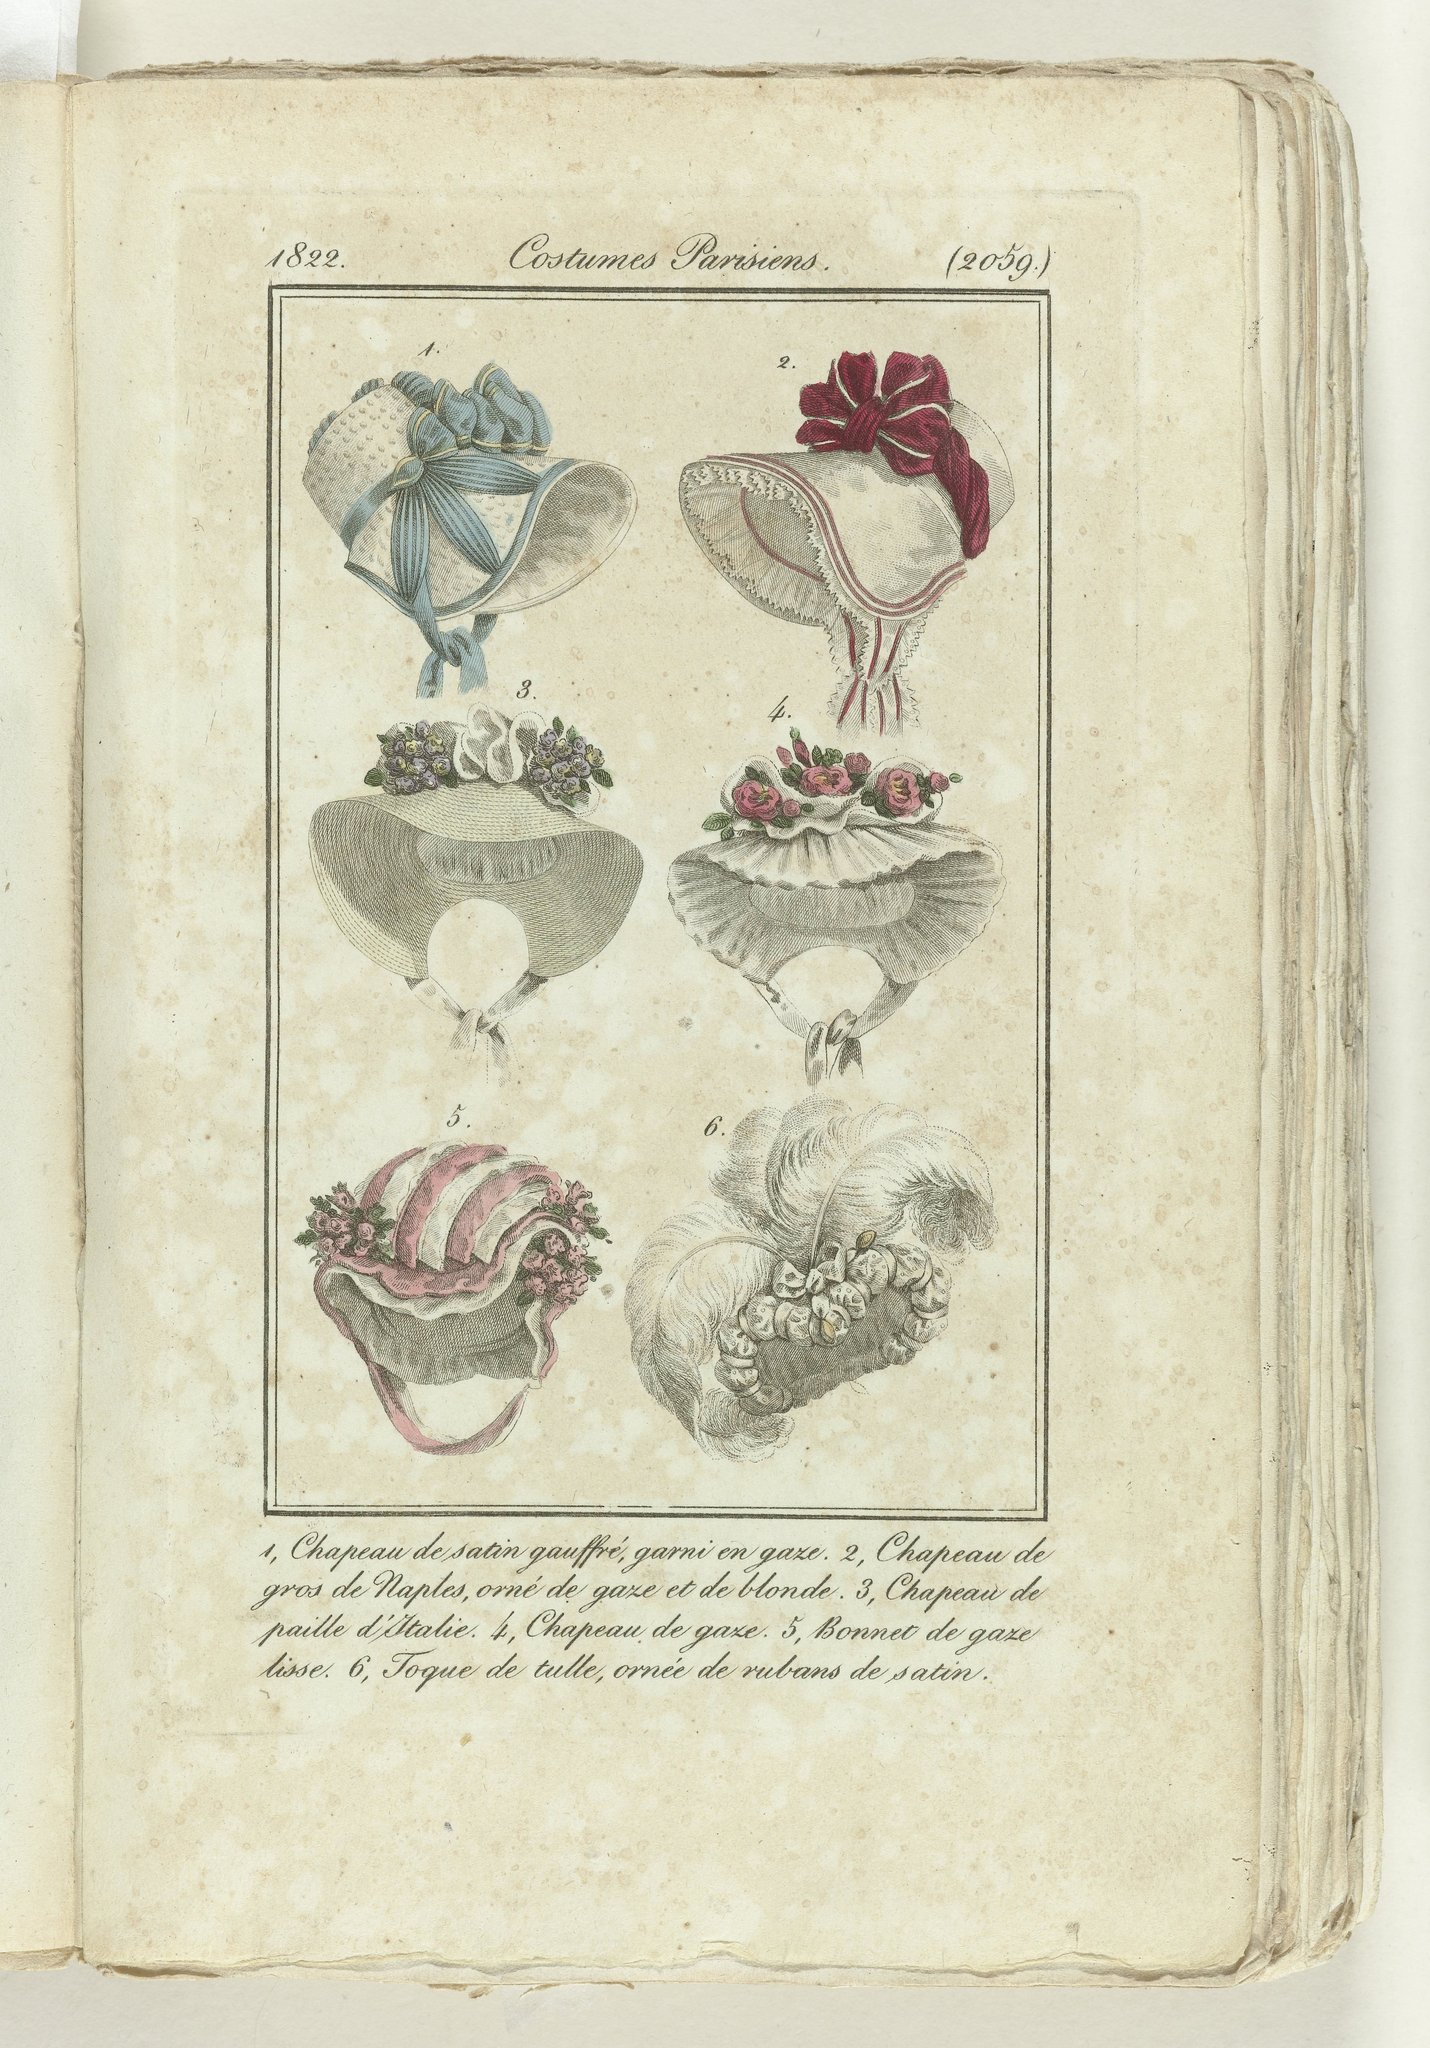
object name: fashion print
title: Journal des Dames et des Modes 1822, Costume Parisien (2059)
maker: Anonymous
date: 1822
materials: paper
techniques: etching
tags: head-gear, fashion plates, clothes, costume (+ women's clothes)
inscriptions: date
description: Prent uit het tijdschrift Journal des Dames et des Modes, 1822.